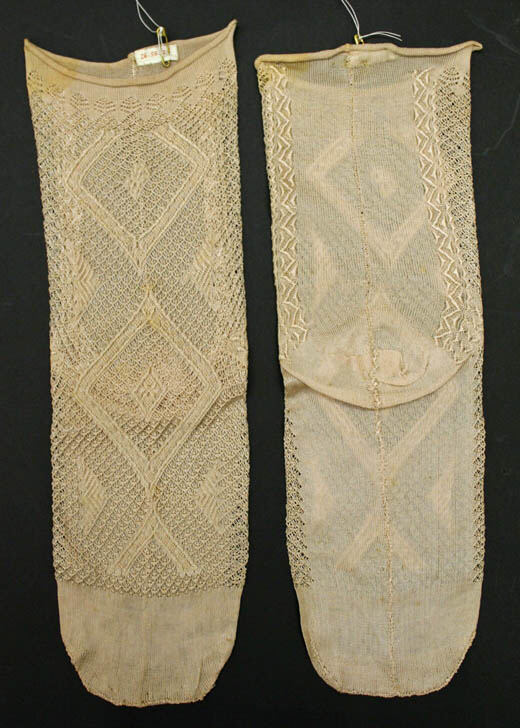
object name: sock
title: Socks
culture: italian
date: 1801-1833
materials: silk